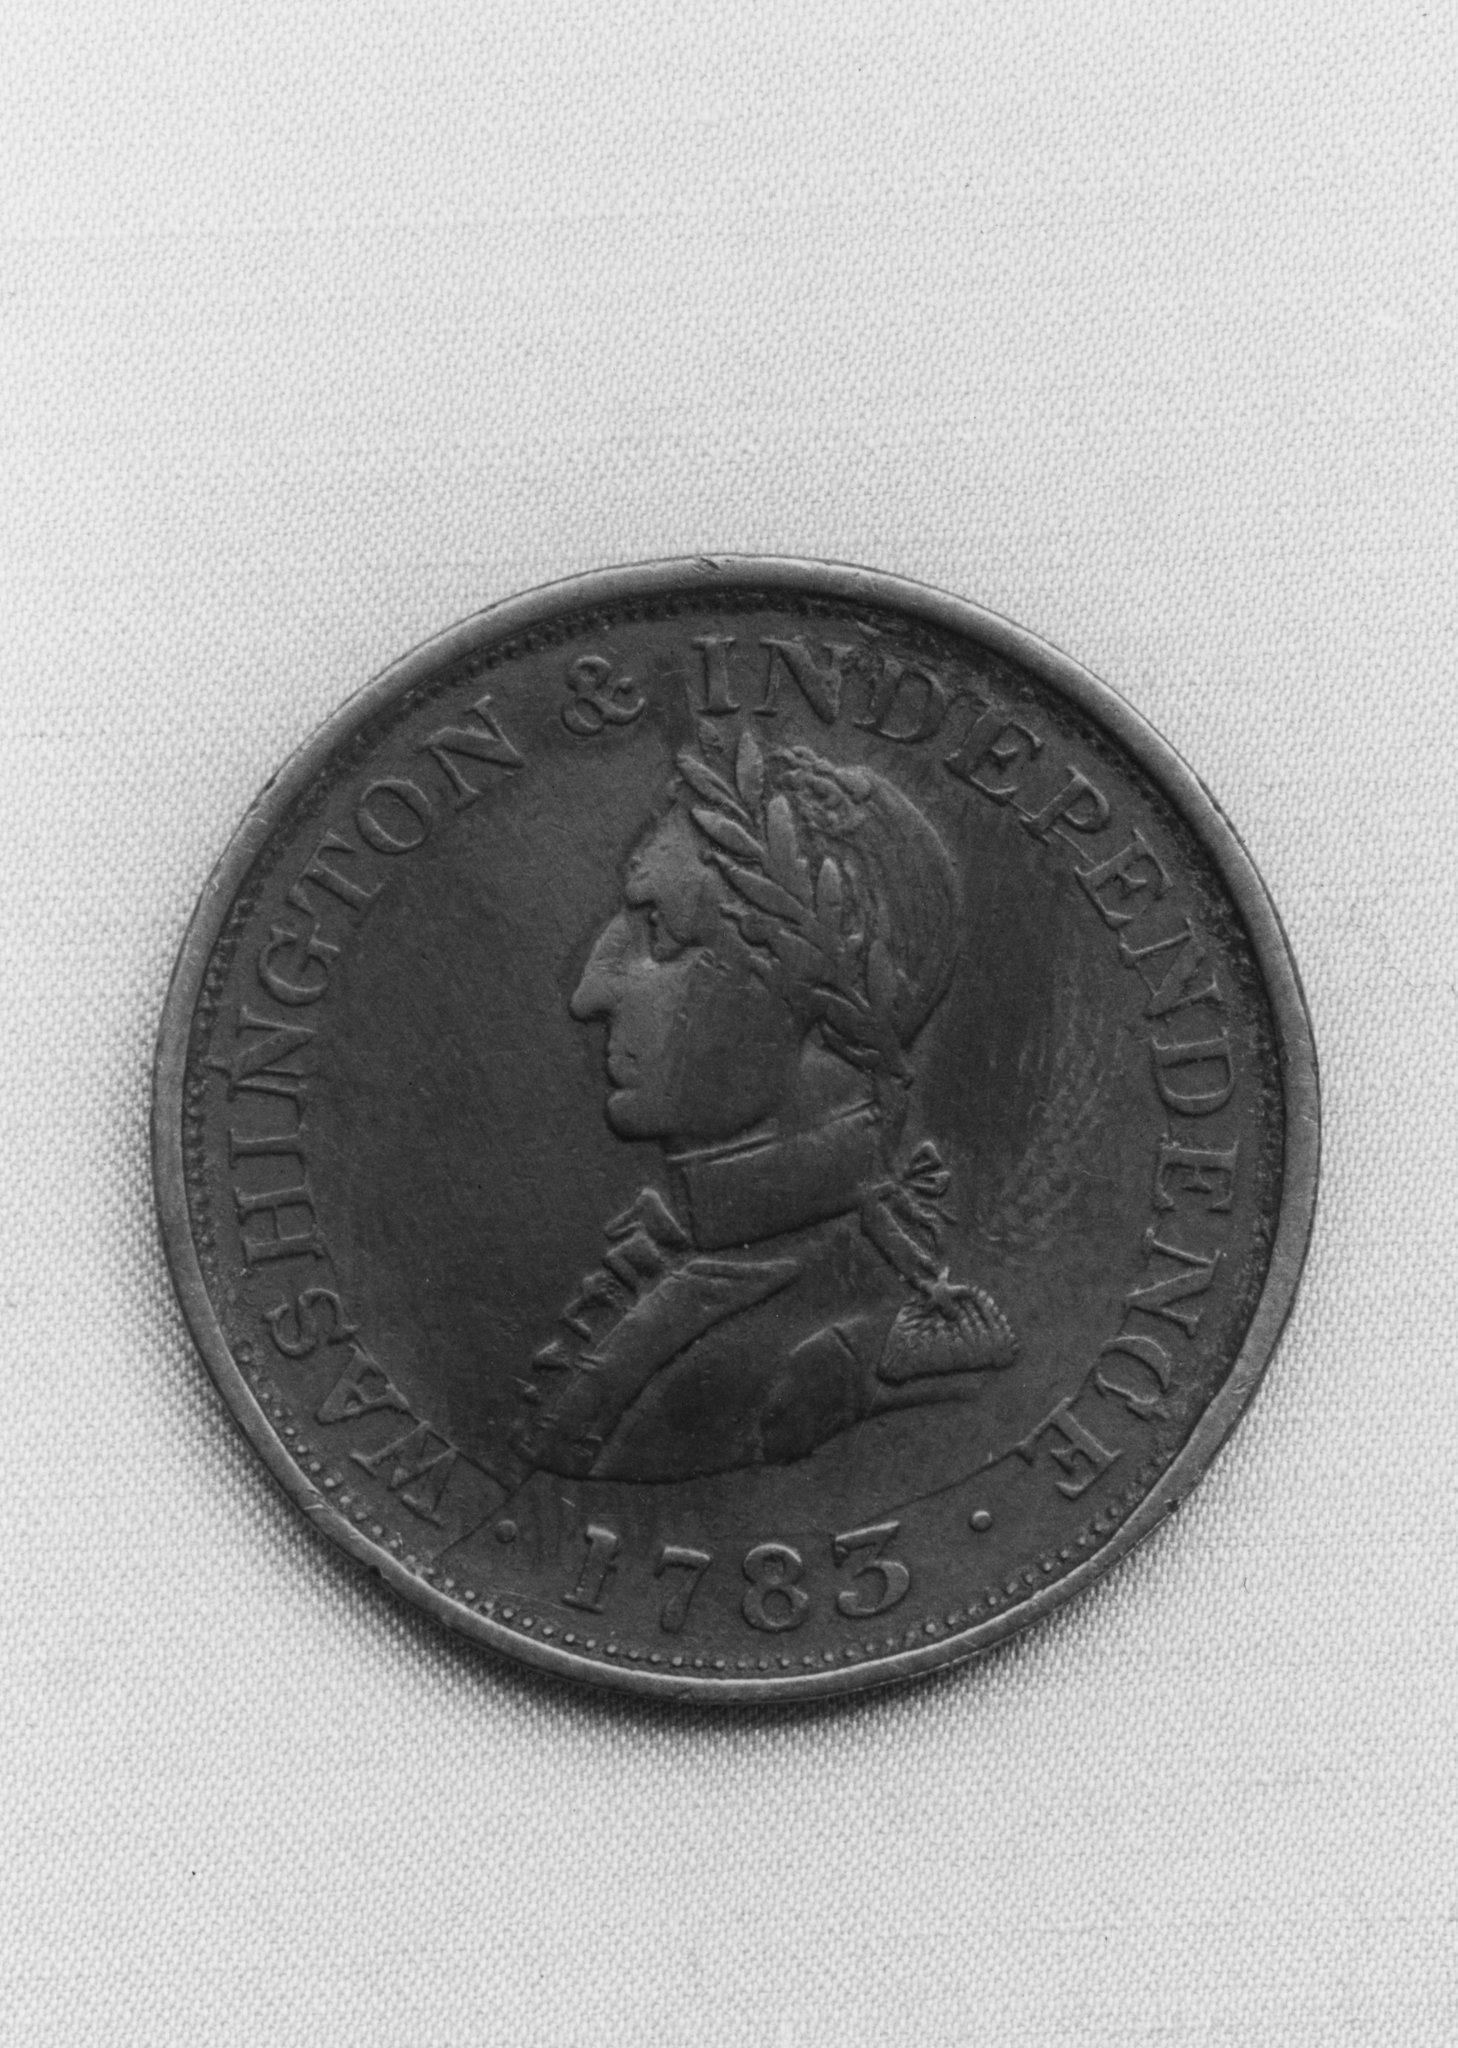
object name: medal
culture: american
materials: copper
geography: united states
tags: men,profiles